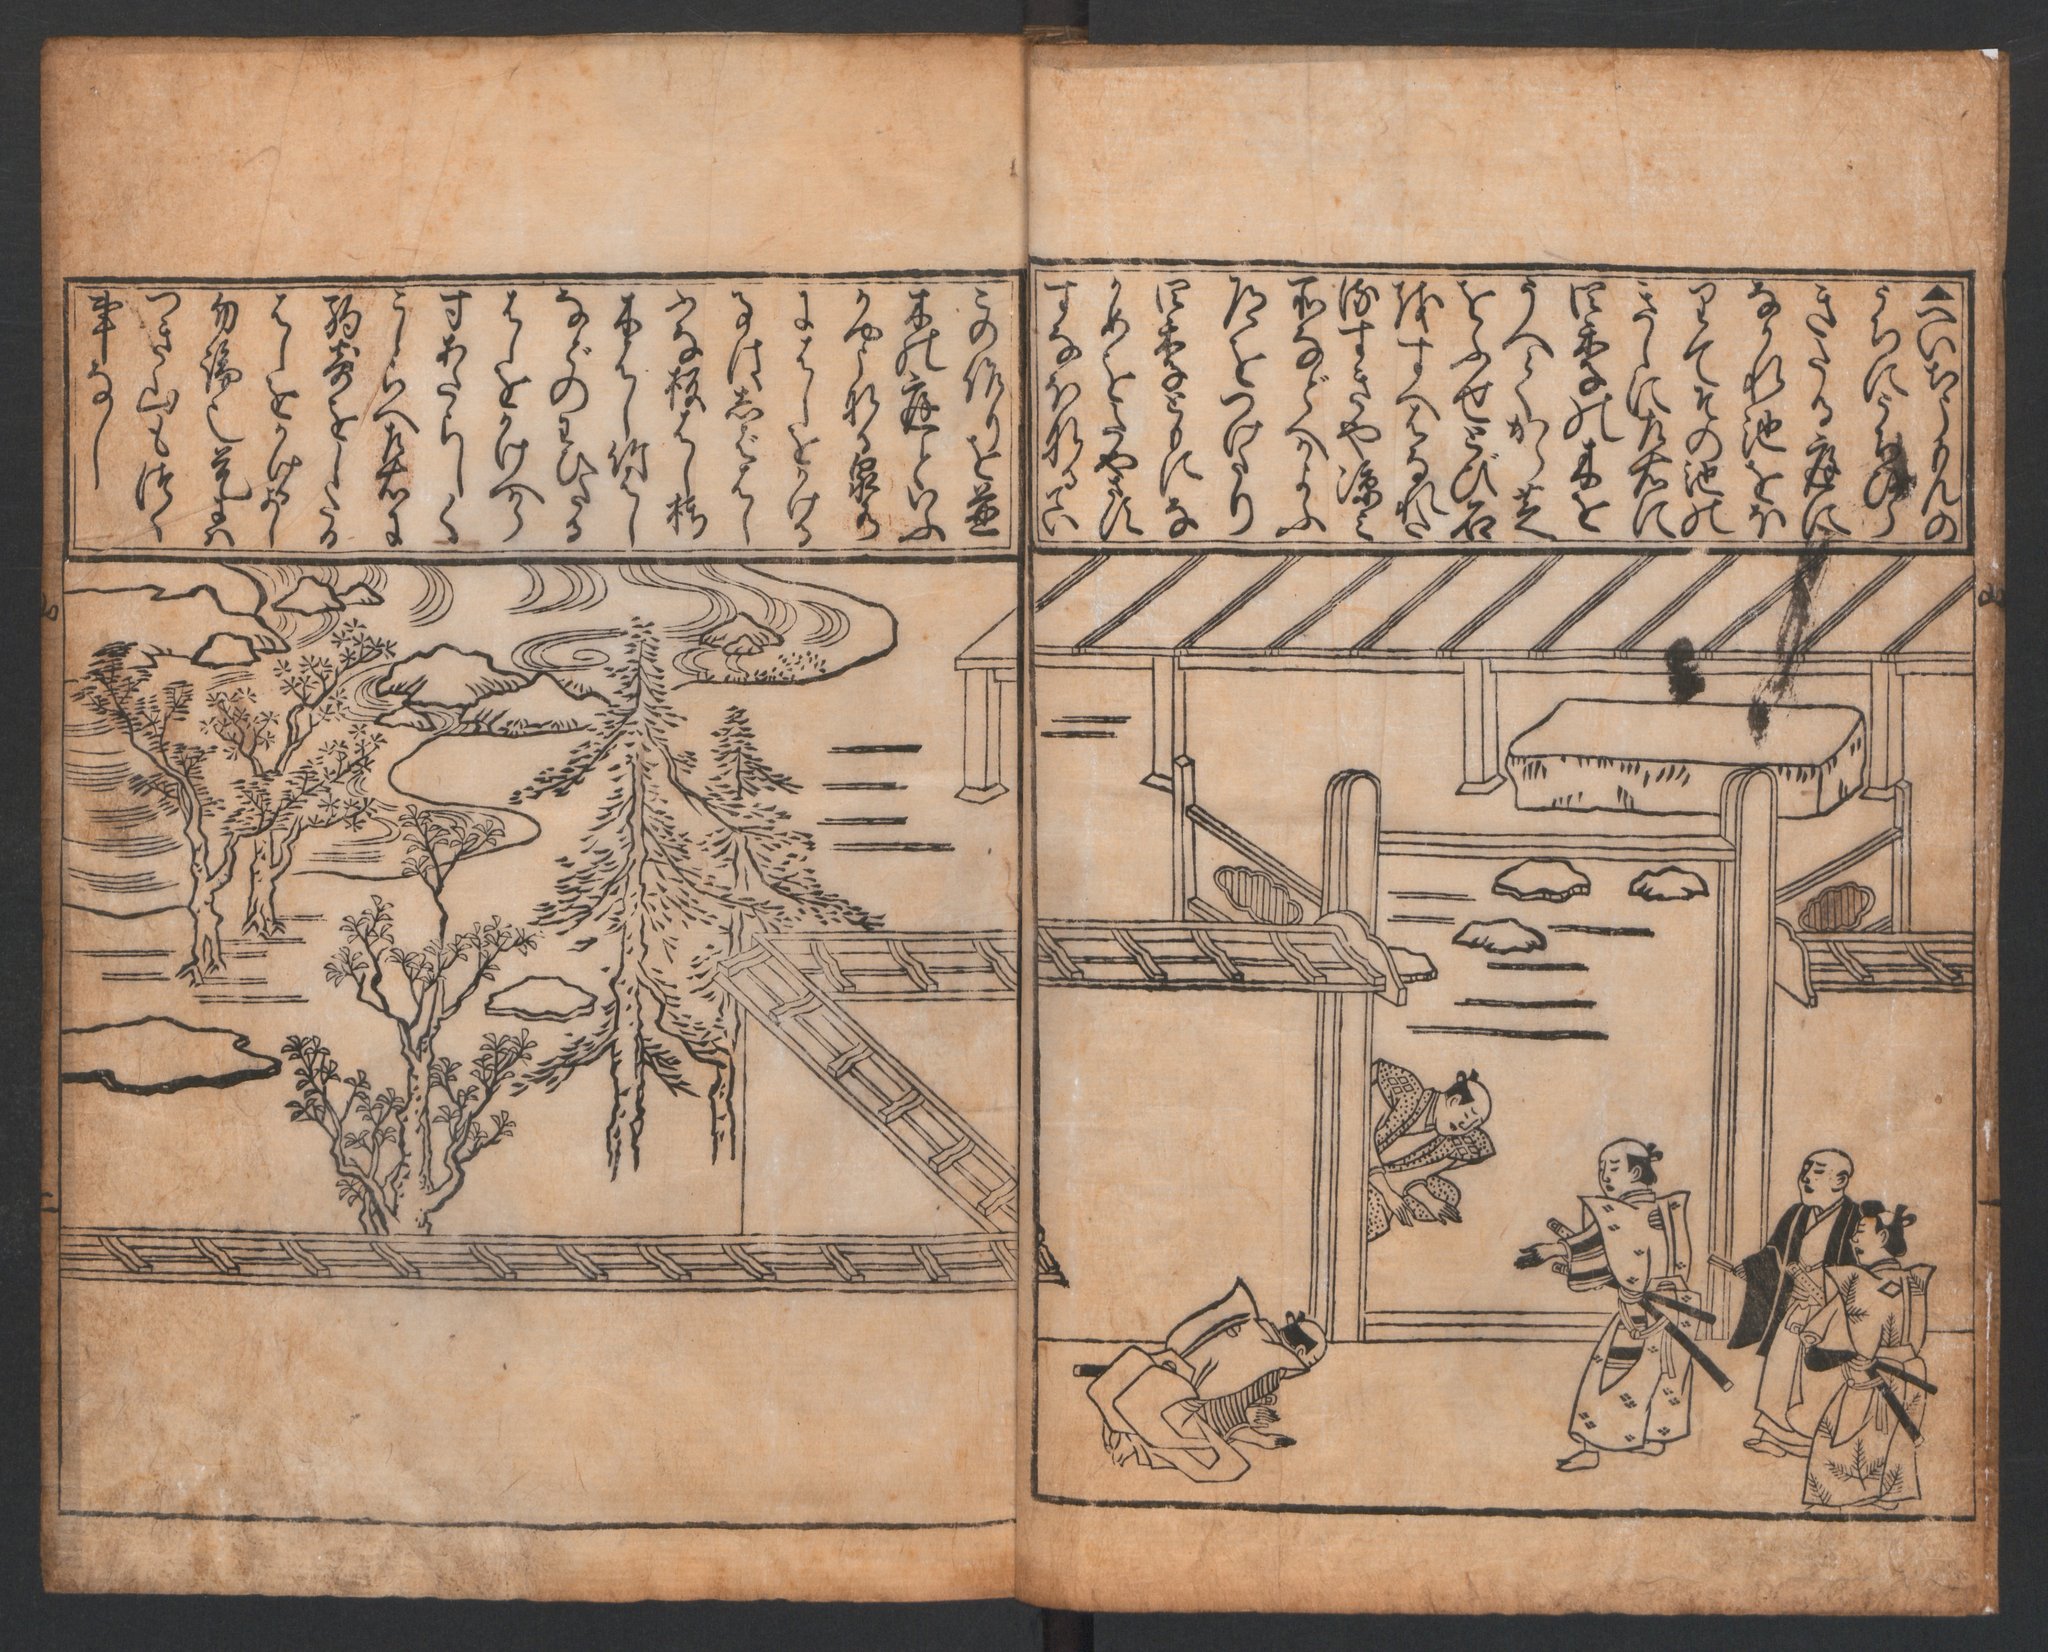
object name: illustrated book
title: A Compendium of Model Gardens (Chikusan zu tei ga; Yokei-tsukuri niwa no zu) 築山図庭畫; 余景作り庭の図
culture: japanese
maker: hishikawa moronobu 菱川師宣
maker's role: artist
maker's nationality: japanese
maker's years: 1618-1694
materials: ink, paper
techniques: woodblock print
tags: gardens